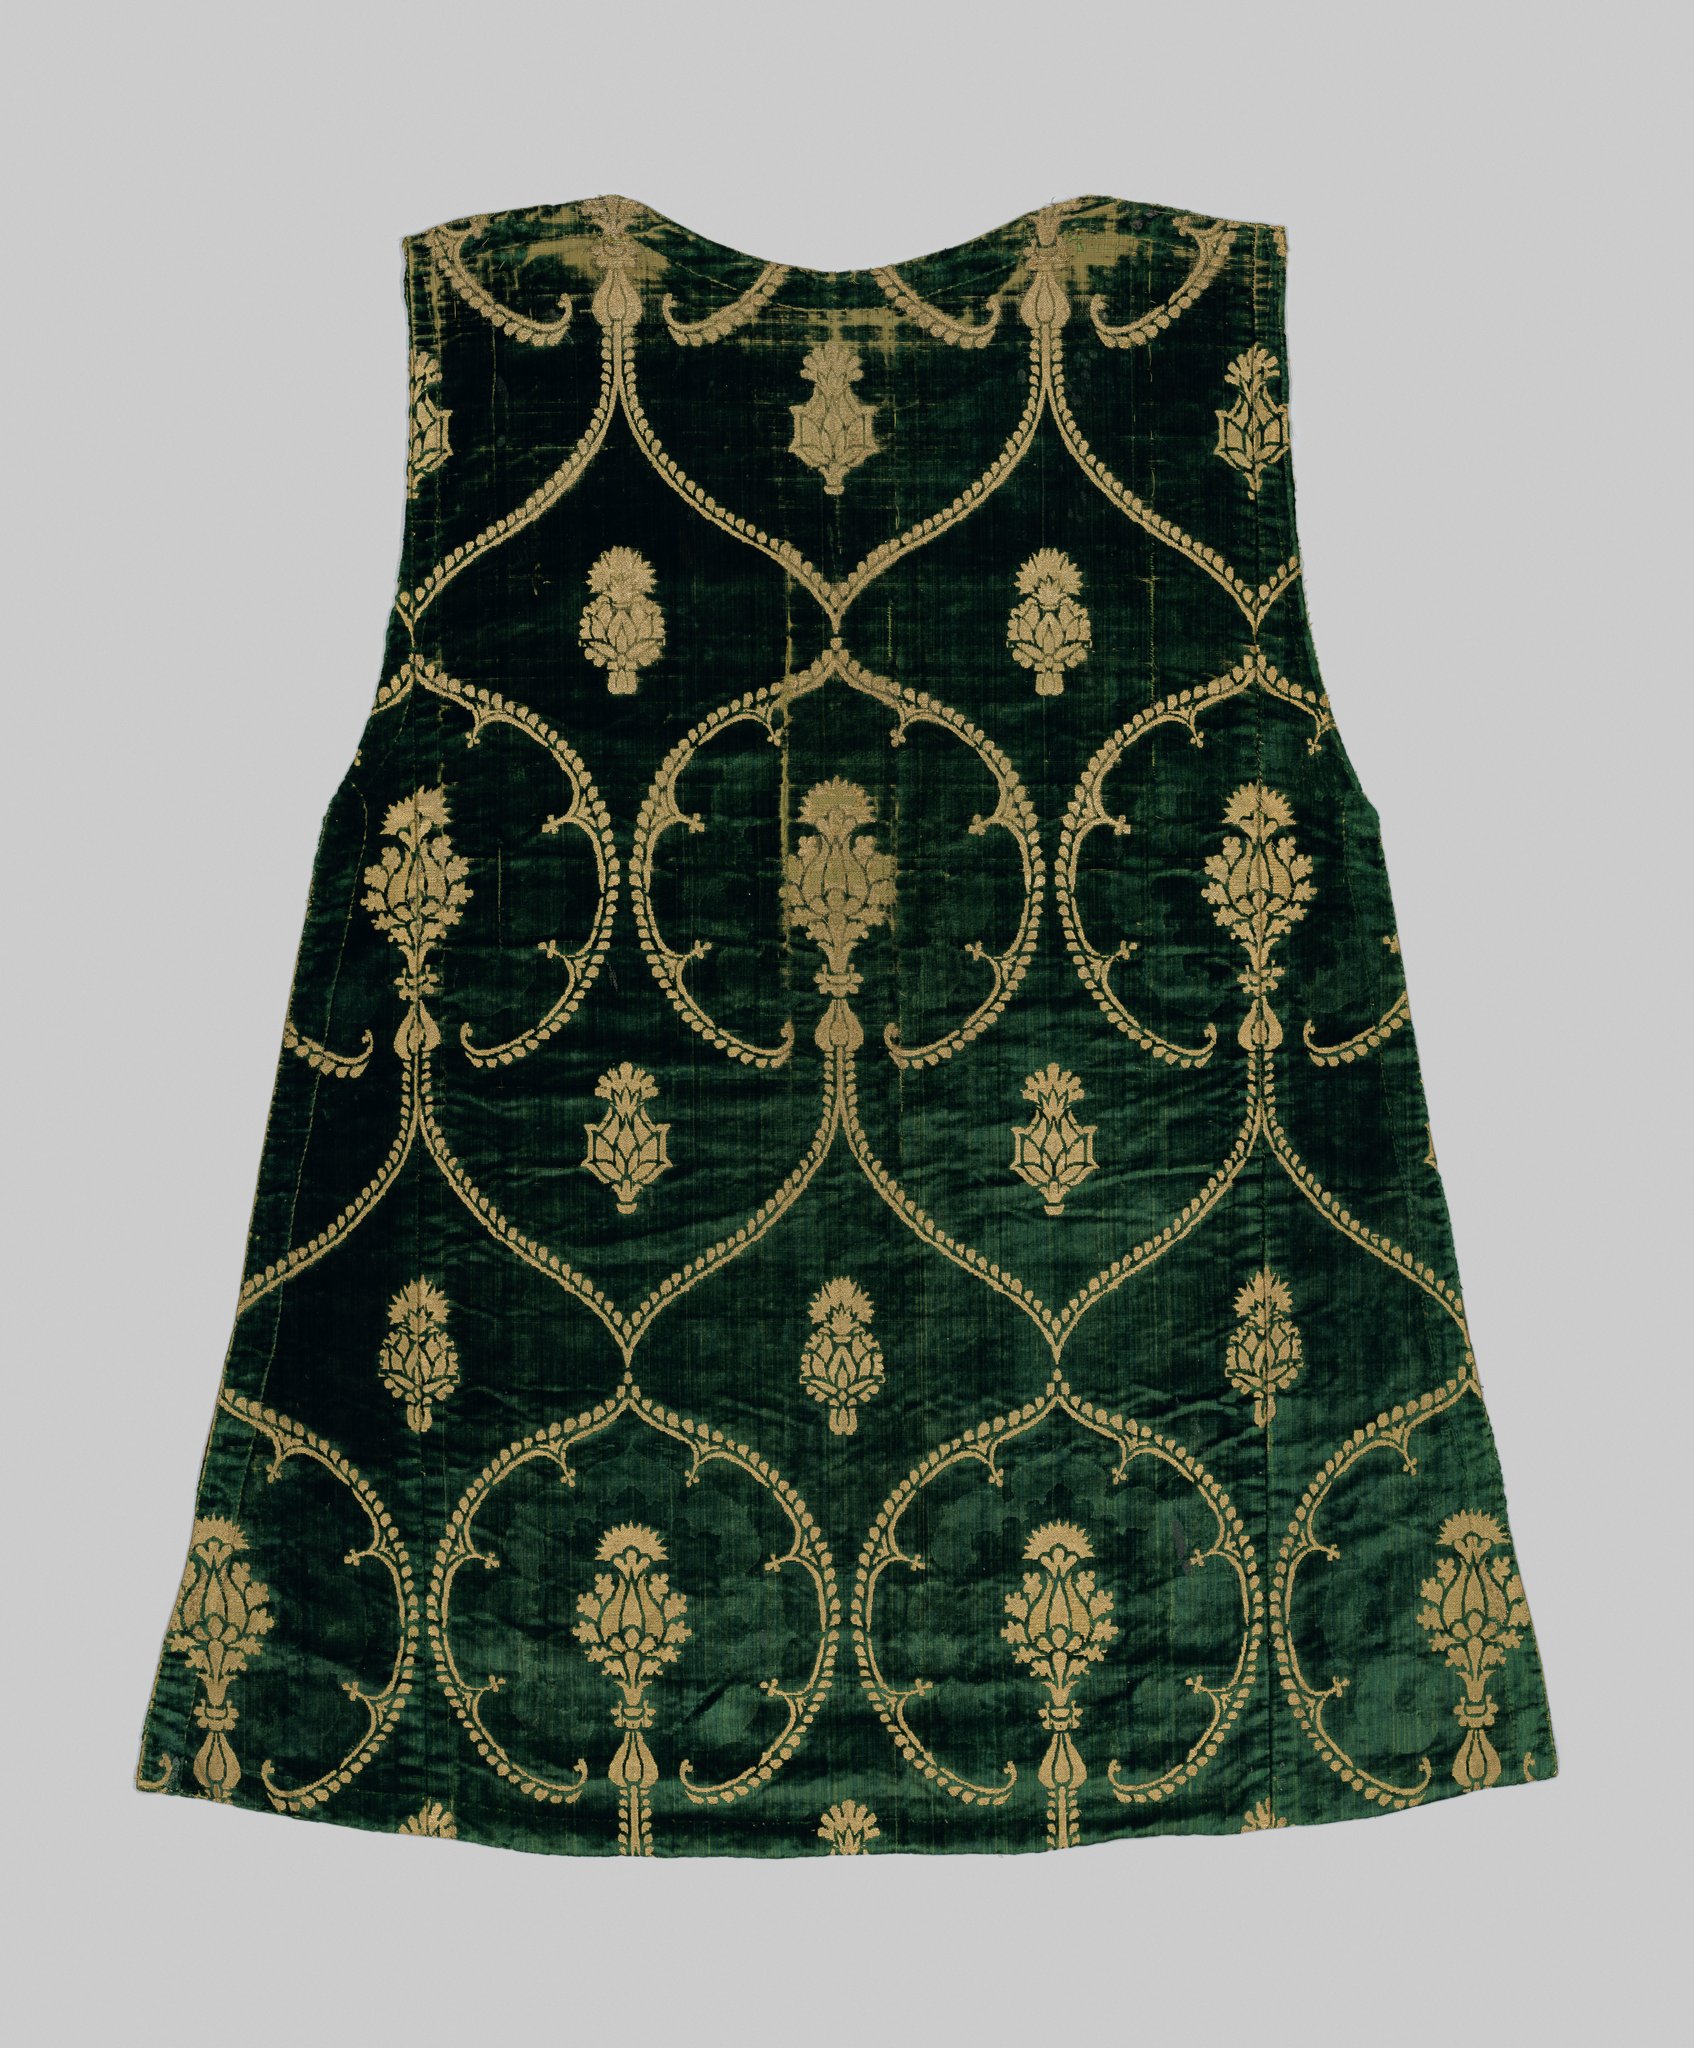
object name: panel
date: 1467-1500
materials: metal thread, silk